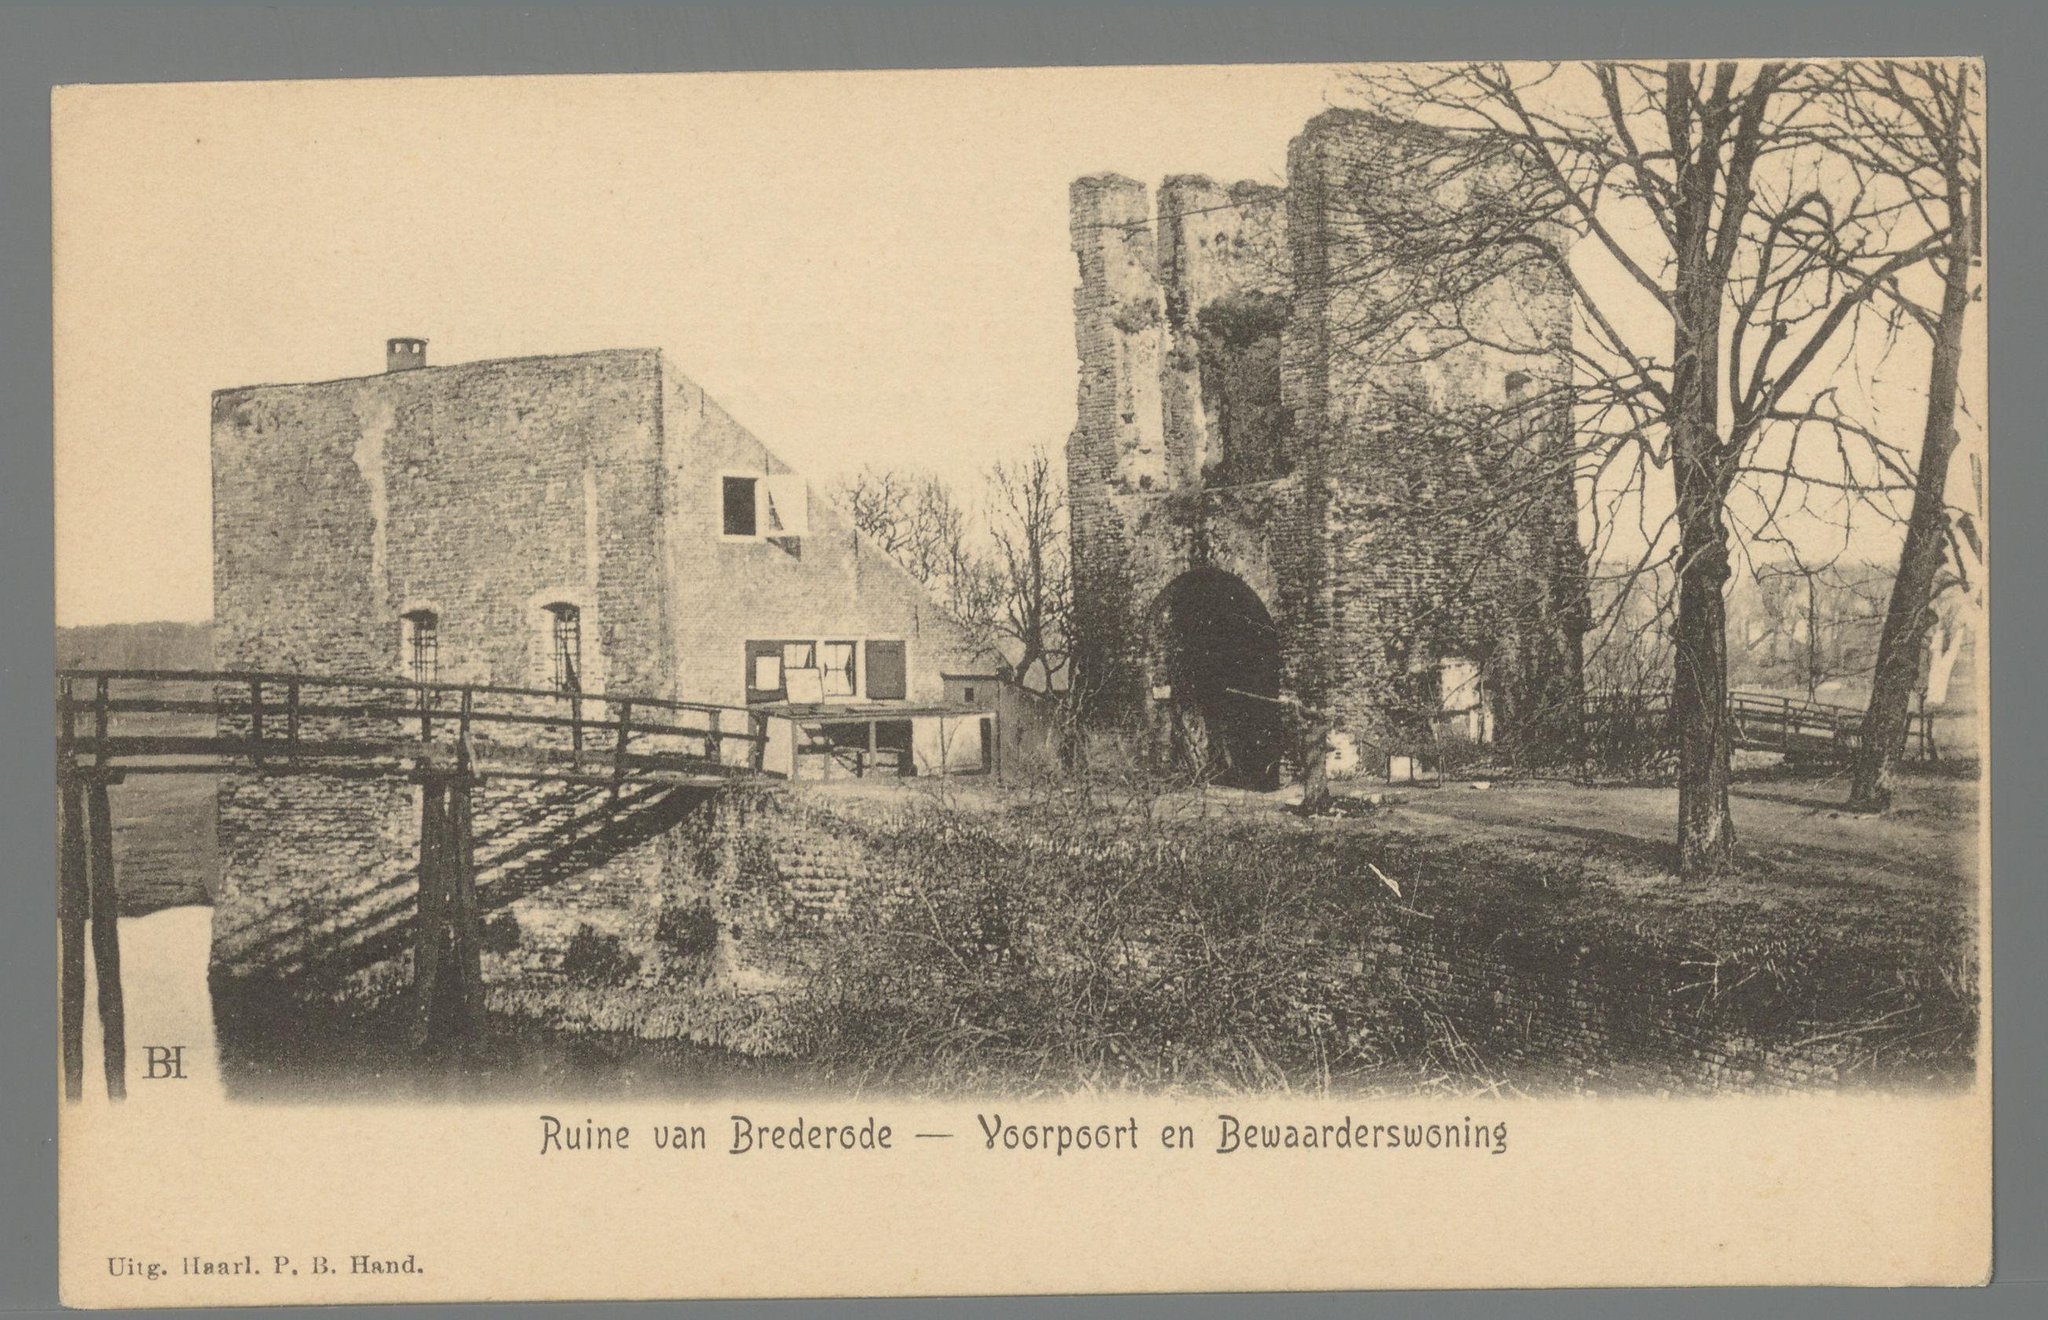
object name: ansichtkaart, prentbriefkaart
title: Ruine van Brederode - voorpoort en bewaarderswoning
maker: Anonymous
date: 1897-1905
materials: cardboard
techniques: photograph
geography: haarlem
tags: castle, bridge in city across river, canal, etc.